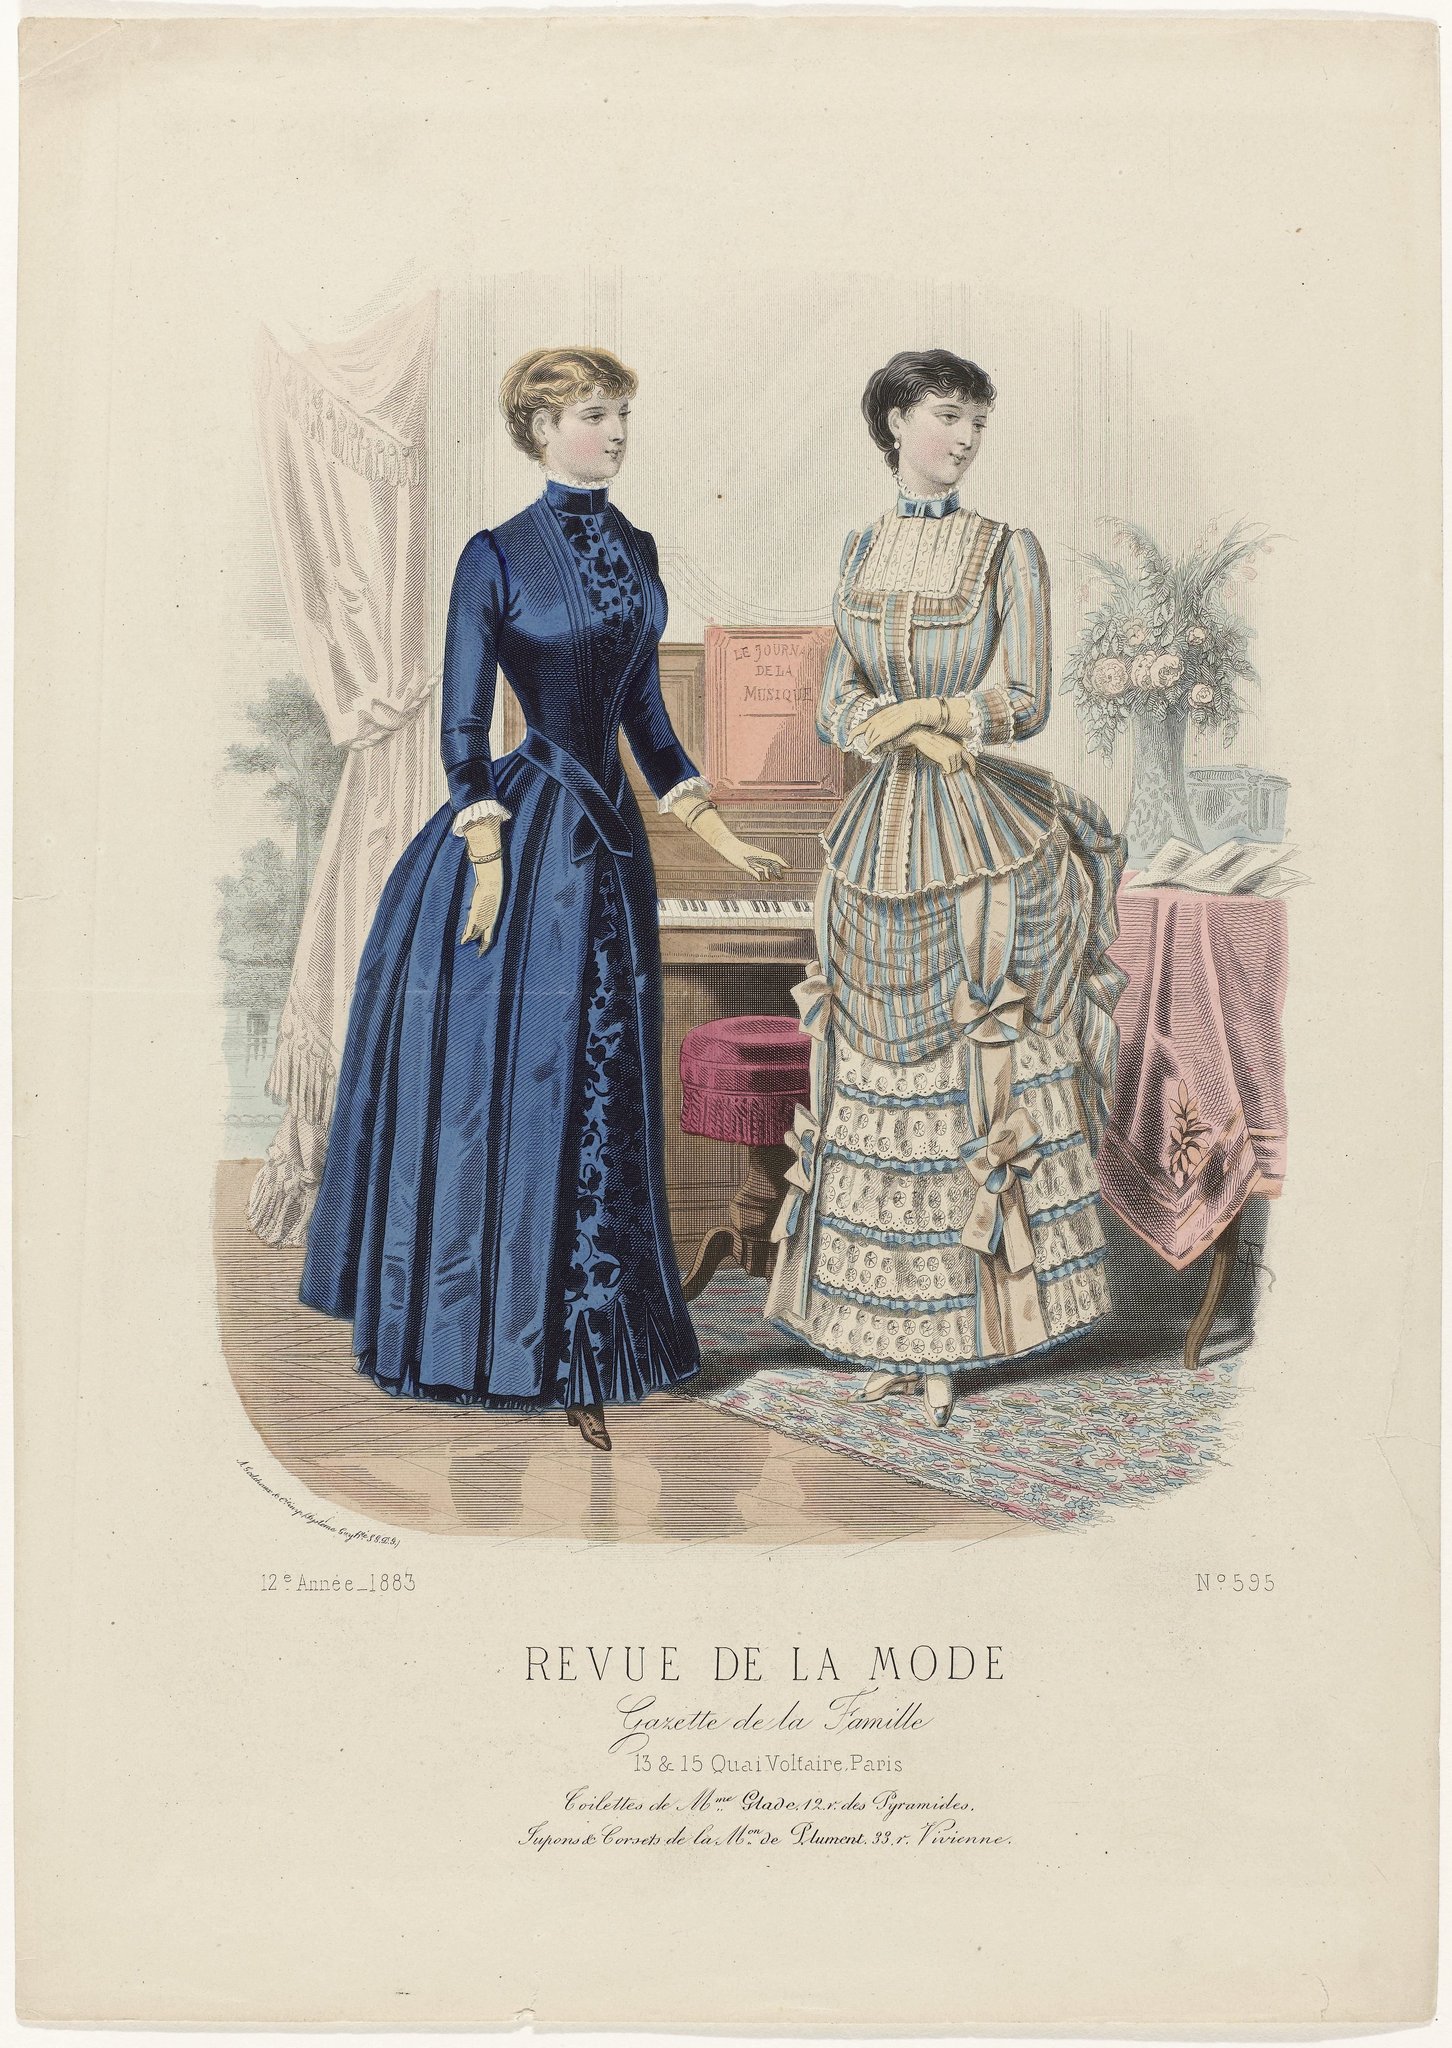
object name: fashion print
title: Revue de la Mode, Gazette de la Famille,dimanche 27 mai 1883, 12e annee, No. 595: Toilettes de M.me Glad (...)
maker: Anonymous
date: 1883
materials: paper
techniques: engraving, hand coloring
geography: paris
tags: dress, gown: redingote (+ women's clothes), piece of clothing covering the breast or décolleté (guimpe) (+ women's clothes), fashion plates, dress, gown (+ women's clothes), pianoforte, parasol, sunshade (+ women's clothes)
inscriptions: title: ‘REVUE DE LA MODE / Gazette de la Famille’, caption: ‘Toilettes de M.me Glade, 12, r. des Pyramides. 104. Jupons & Corsets de la Mo.n de Plument, 33, r. Vivienne.’, address: ‘13 & 15, Quai Voltaire Paris’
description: Twee vrouwen, gekleed in japonnen van Glade, in een interieur bij een piano. Op de pianostandaard bladmuziek 'Le jounal de la musique'. Links: robe redingote van blauw 'satin ottoman' (satijn) en tablier gilet van 'gaze de velours'. Rechts: 'toilette' met blauw-beige strepenmotief. Guimpe van kant. Onder de afbeelding een regel reclametekst voor verschillende producten. Prent uit het modetijdschrift Revue de la Mode (1872-1913). Uitgebreide beschrijving van de kleding op pagina 166 "PLANCHE COLORIÉE".